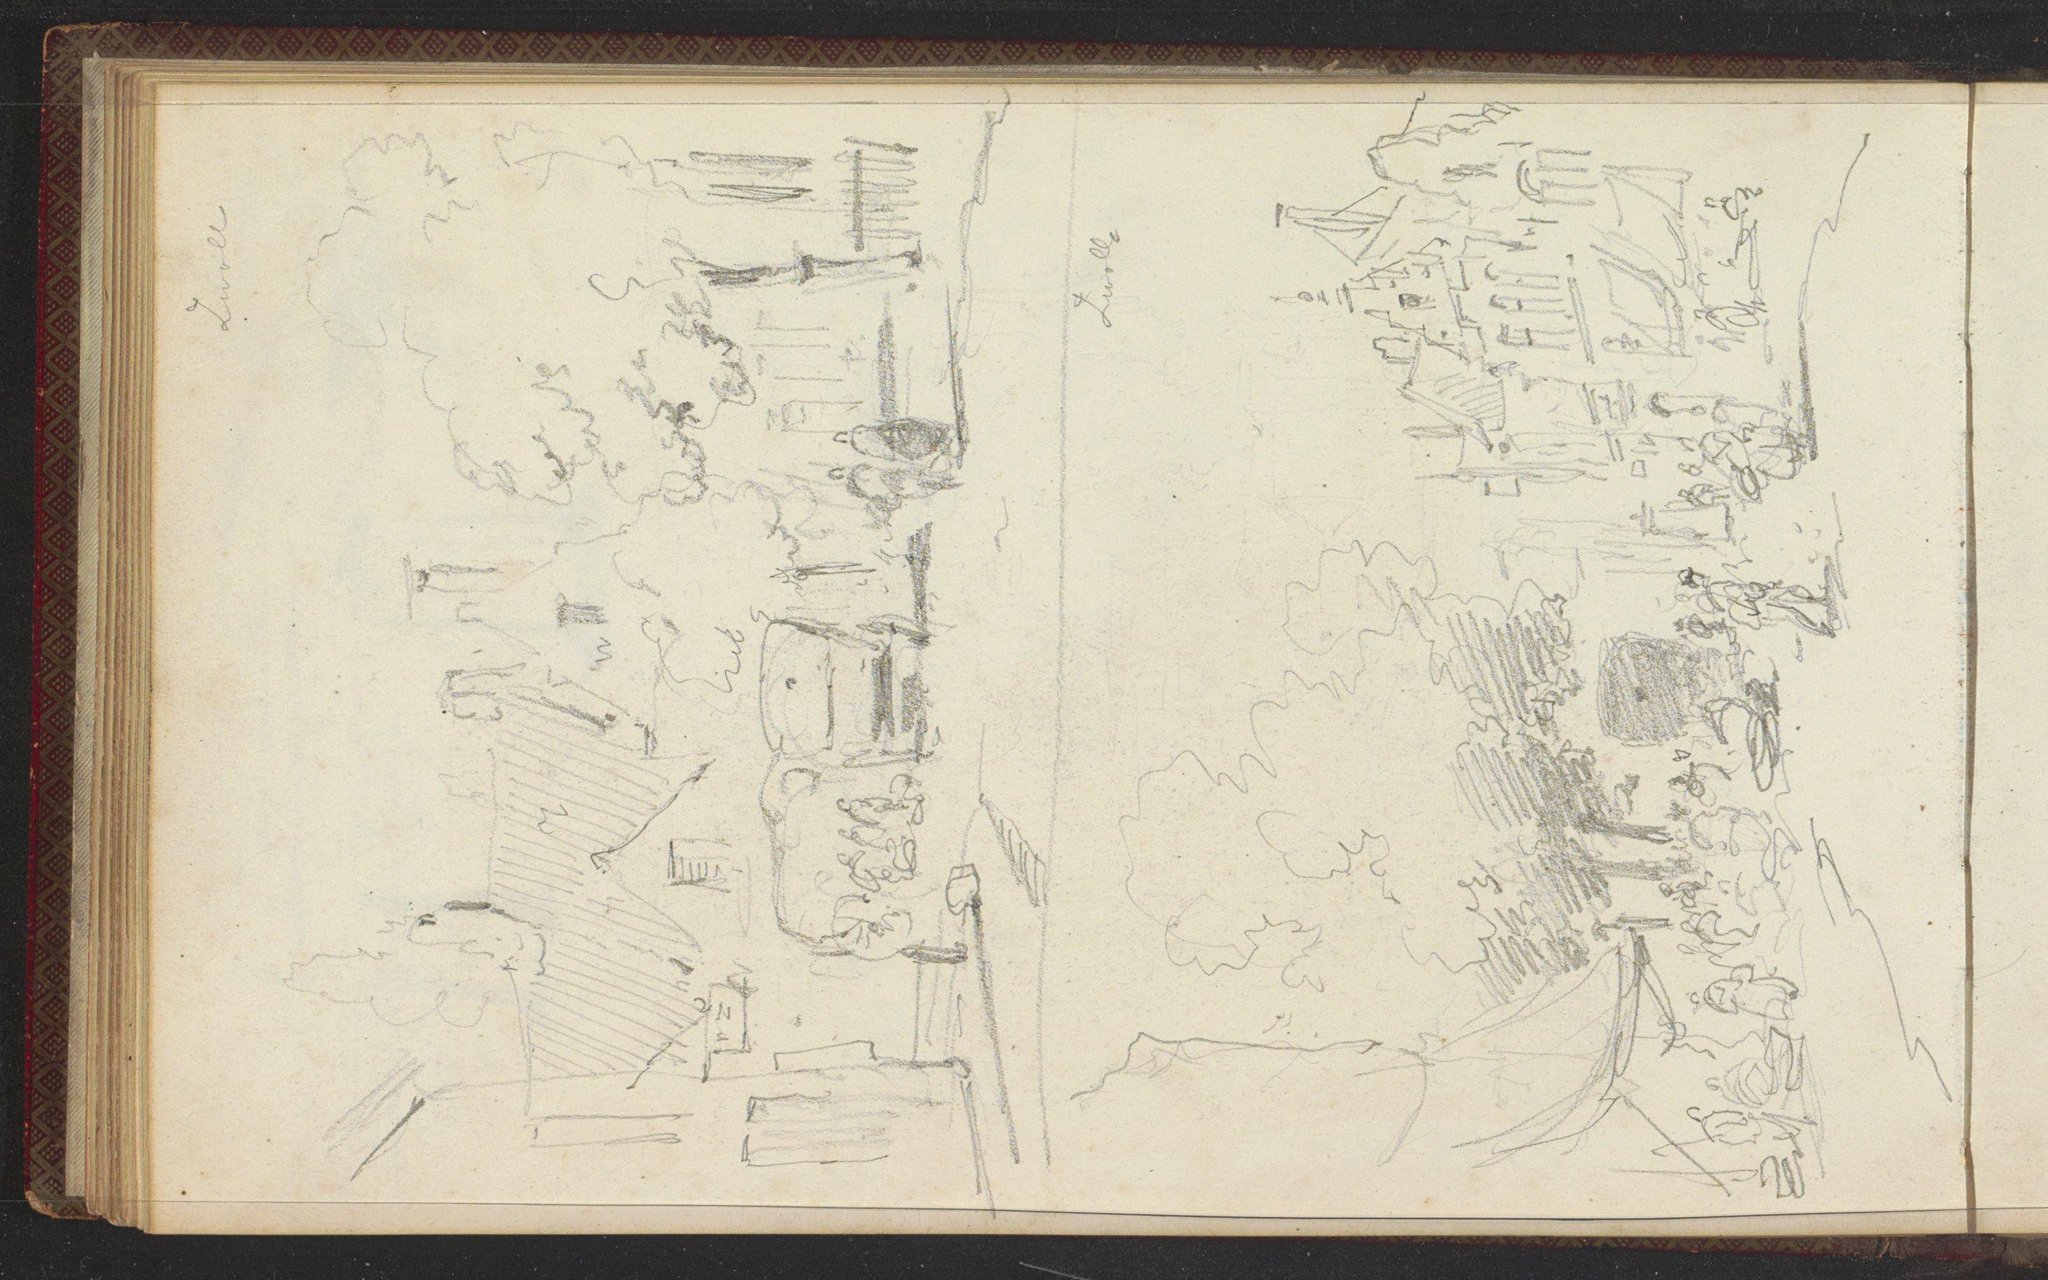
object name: sketchbook leaf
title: Twee stadsgezichten in Zwolle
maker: adrianus eversen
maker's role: draughtsman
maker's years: 1818-1897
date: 1828-1897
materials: paper, pencil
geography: zwolle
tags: urban housing, street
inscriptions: annotation: ‘Zwolle/ Zwolle’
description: Twee stadsgezichten in Zwolle. Boven een gezicht op een straat of plein met huizen, bomen, figuren en een rijtuig. Onder een gezicht op een straat met aan weerszijden gebouwen. Links een gebouw met een luifel. Op straat een rijtuig en figuren. Blad 27 verso uit een schetsboek met 52 bladen vervaardigd in de omgeving van Kampen, Hattem, Hoorn en Zwolle.